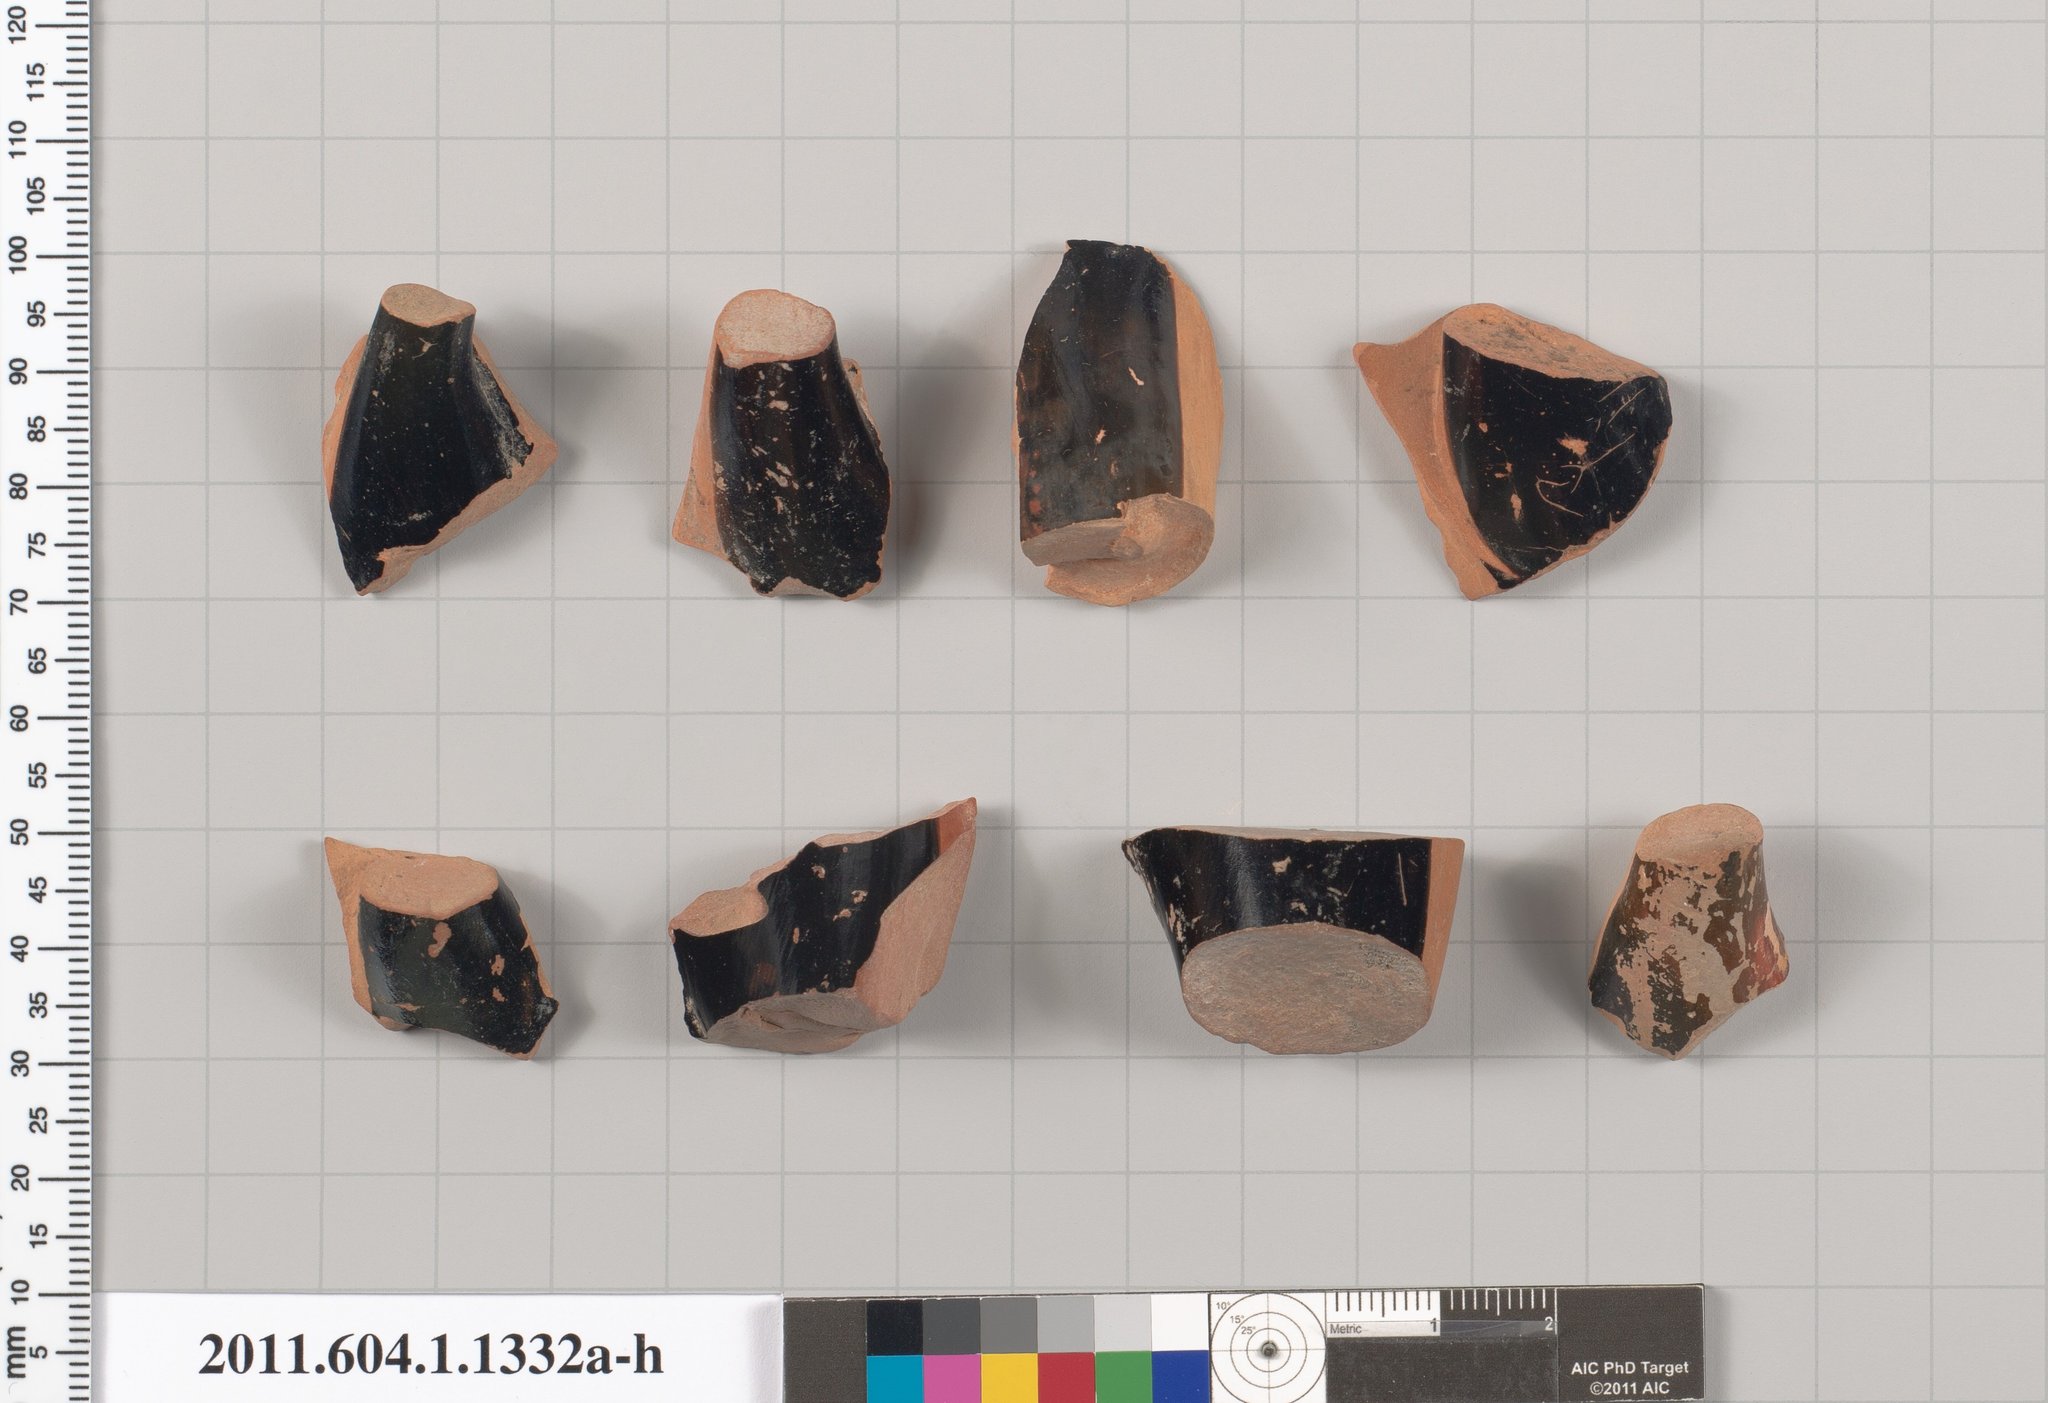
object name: kylix fragment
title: Terracotta fragments of kylikes (drinking cups)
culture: greek, attic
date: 500-401 BCE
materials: terracotta